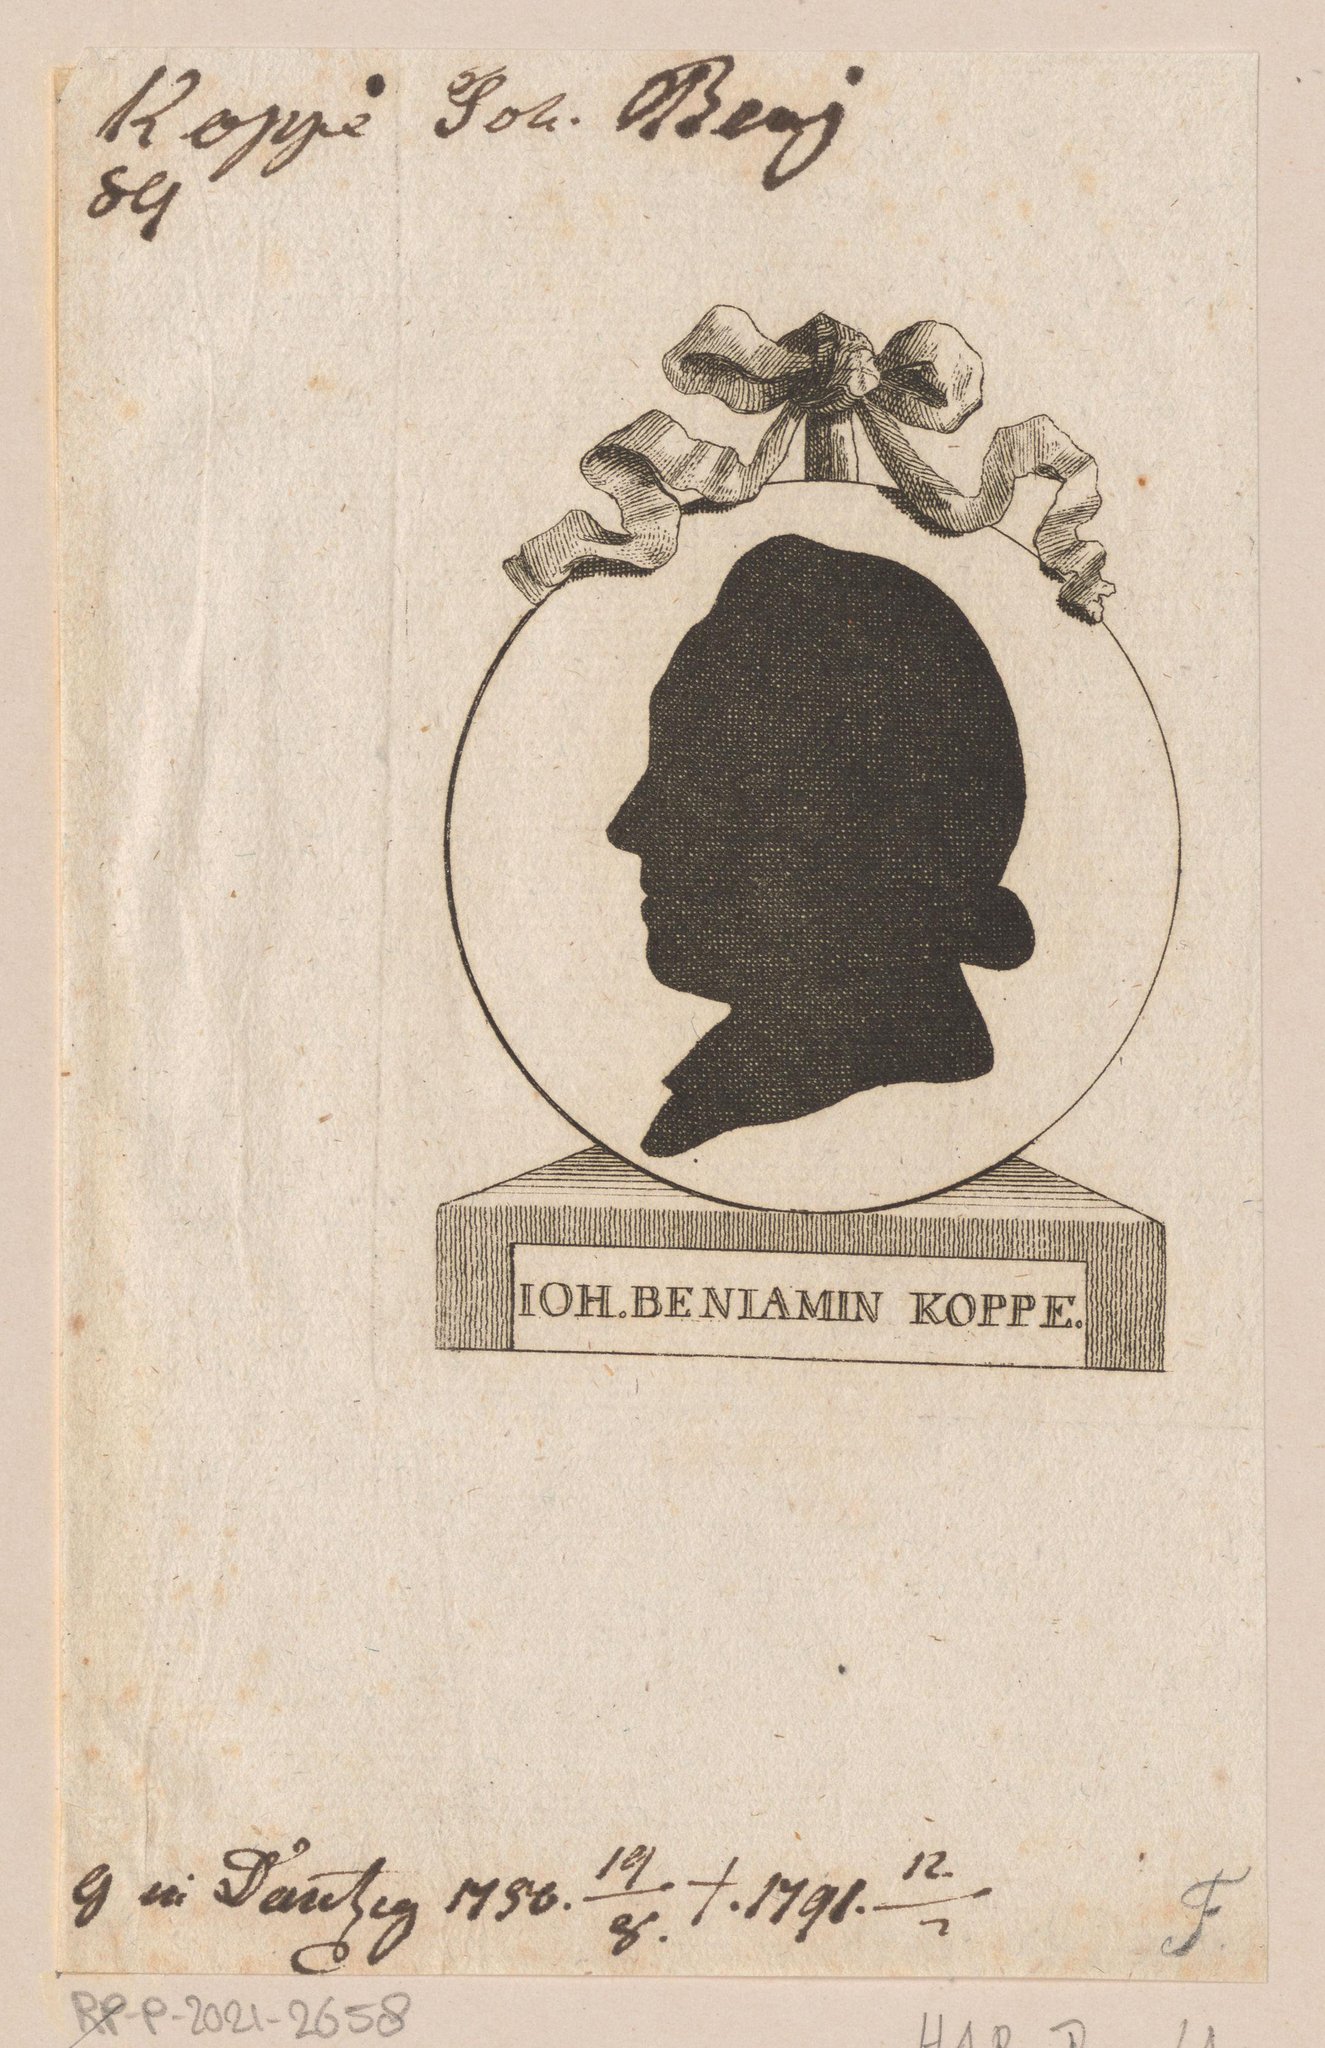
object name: print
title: Silhouetportret van Johann Benjamin Koppe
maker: Anonymous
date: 1783-1784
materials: paper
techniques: etching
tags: historical persons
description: Prent mogelijk uit: Hendel, Johann Christian. Schattenrisse edler Teutschen: aus dem Tagebuche eines physiognomischen Reisenden. Halle: s.n., 1783-1784.